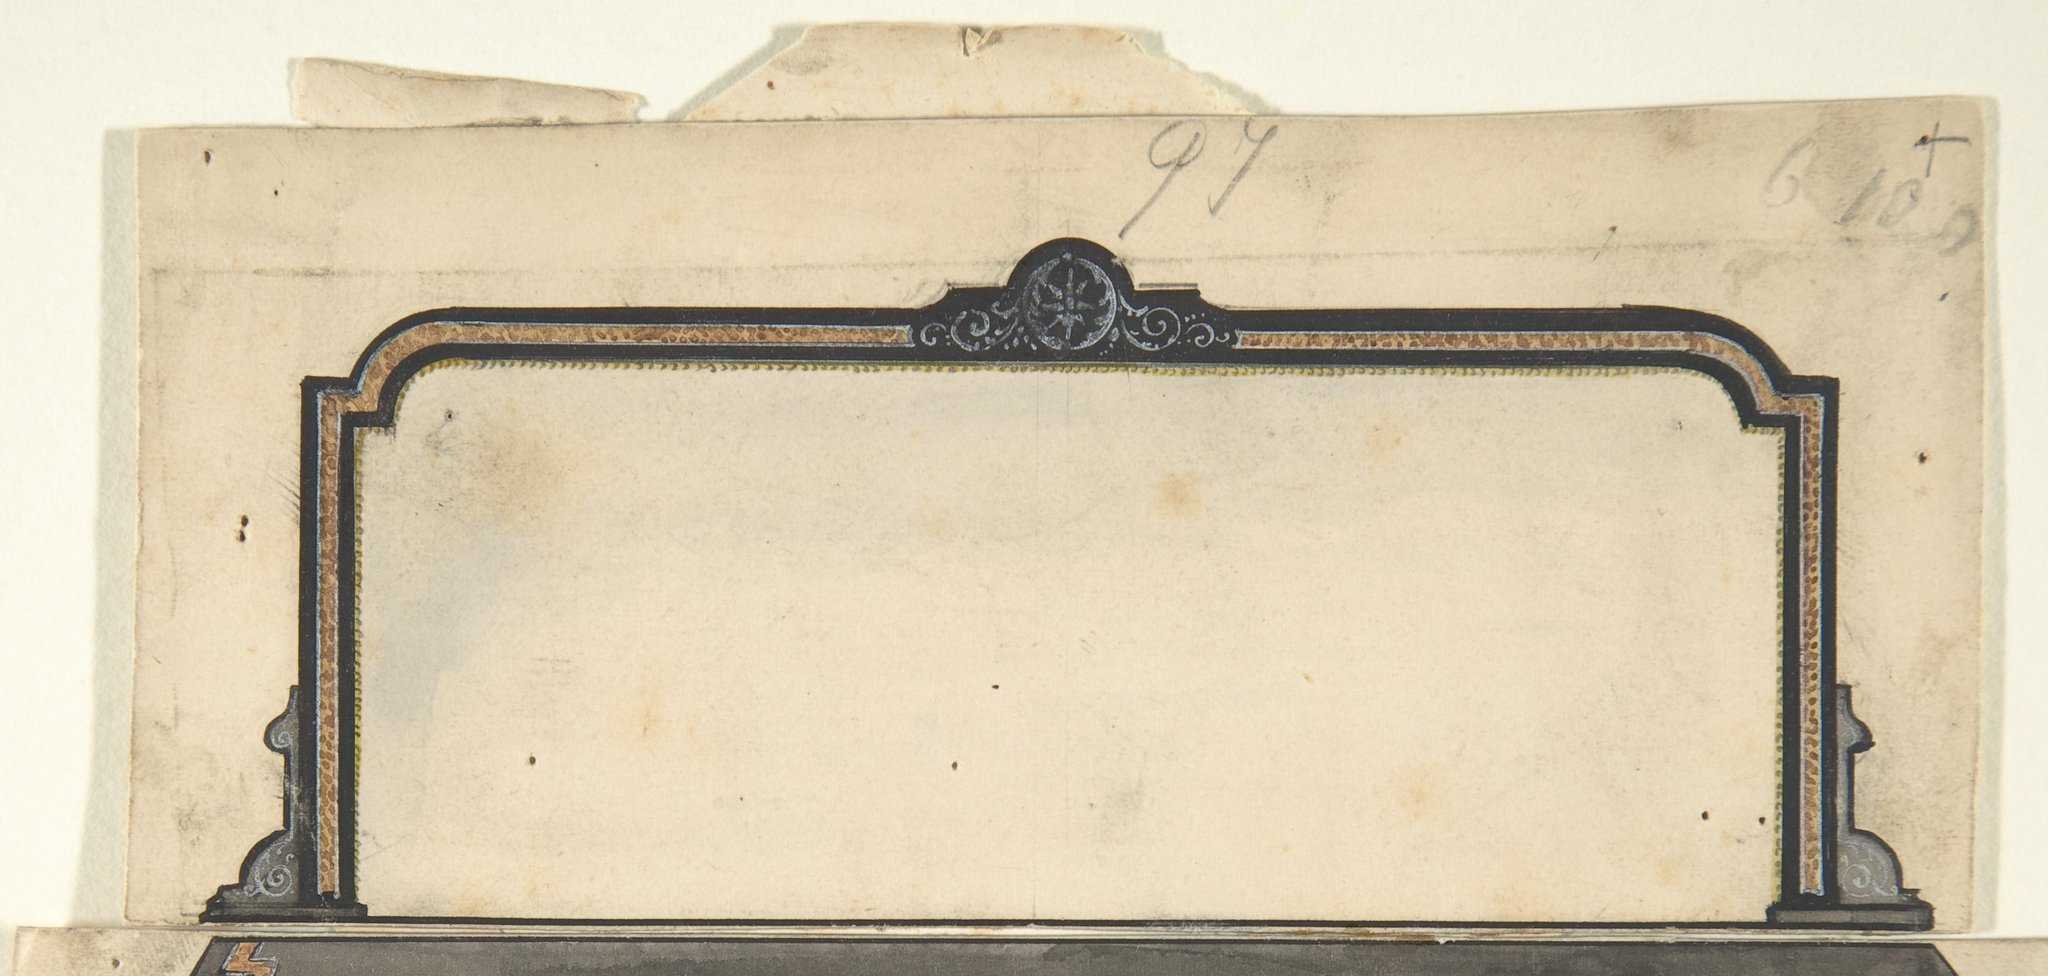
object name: drawing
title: Design for a Mirror to go over a Cabinet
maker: anonymous, british, 19th century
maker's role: artist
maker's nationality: british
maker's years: 1800-1900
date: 1801-1900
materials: ink, watercolor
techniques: pen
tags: mirrors